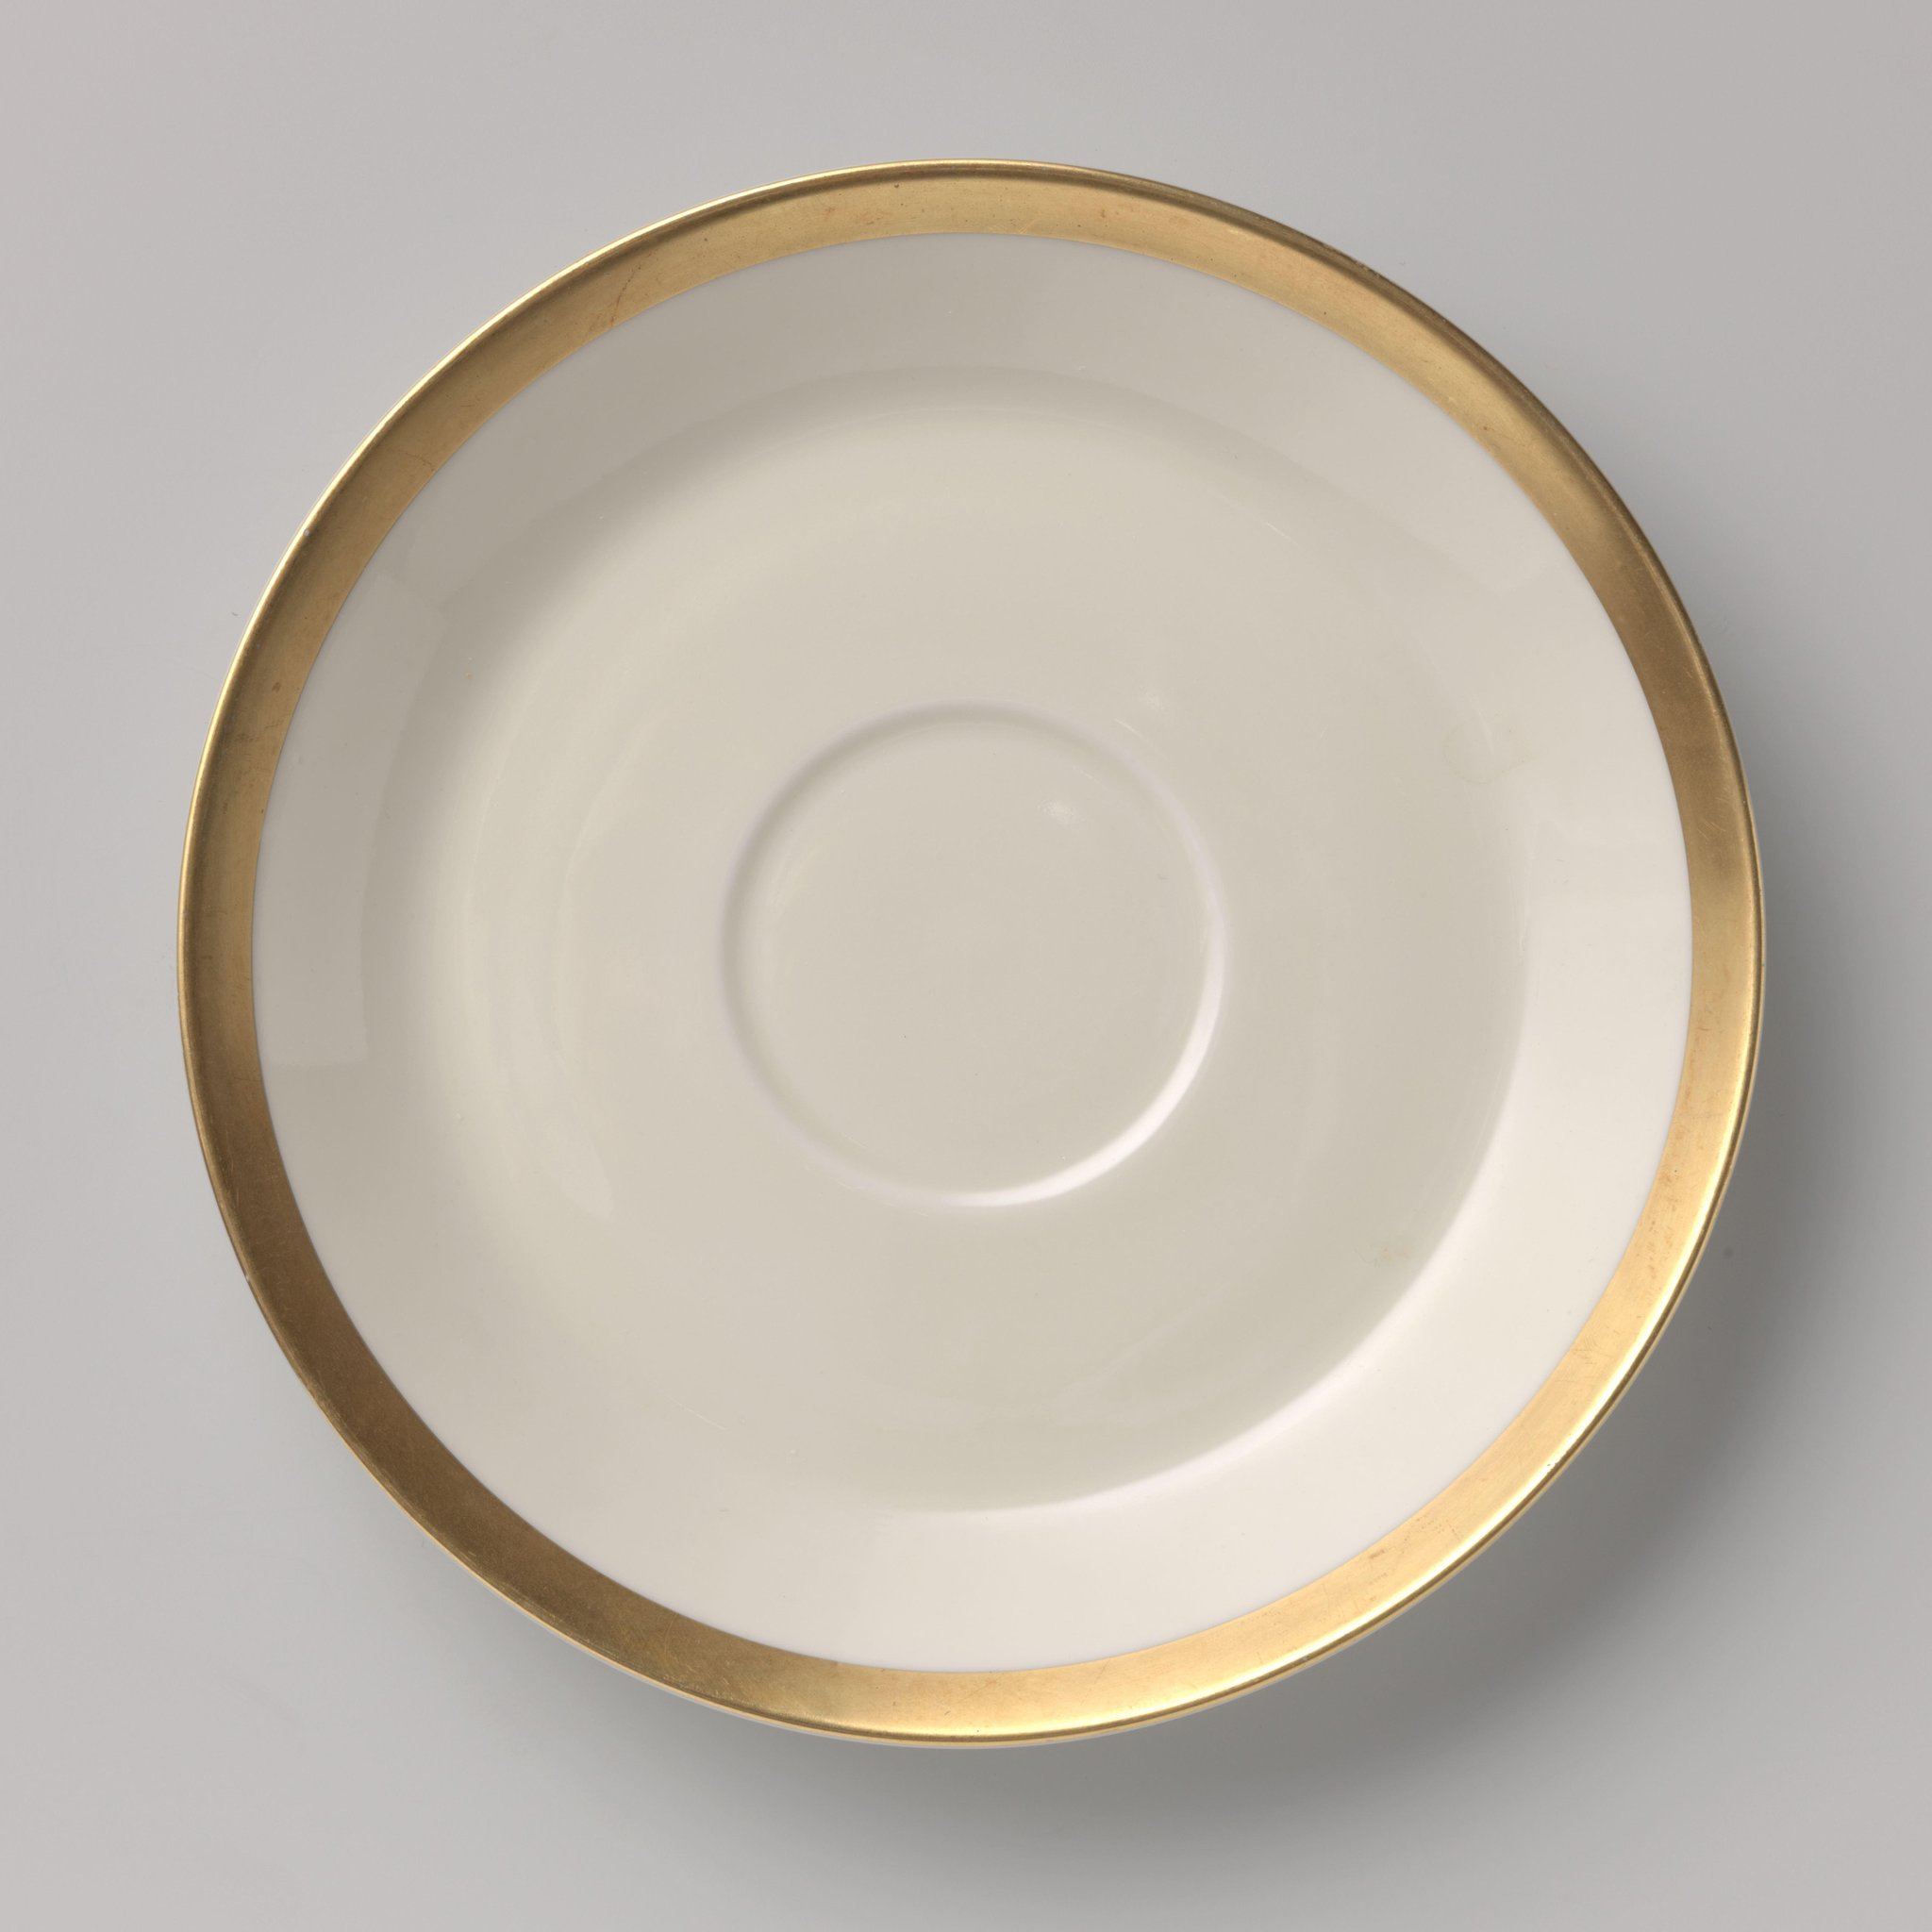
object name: platter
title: Dish used in the House of Representatives of the Netherlands at official receptions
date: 1900-1974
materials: glaze, gold, paint, porcelain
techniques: firing, forming, vitrification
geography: bavaria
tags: rotterdam, brussels, the hague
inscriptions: mark: ‘Hutschenreuther Selb/ leeuw met L.H.S. Germany/ Noblesse/ P.A.W. Philippona Den Haag’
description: Schotel van servies gebruikt bij Tweede Kamer der Staten Generaal bij officiële ontvangsten. Klein bord van luxe diner-set met gouden randje en het wapen van de Tweede Kamer. Gebruikt bij Tweede Kamer der Staten Generaal bij officiële ontvangsten.